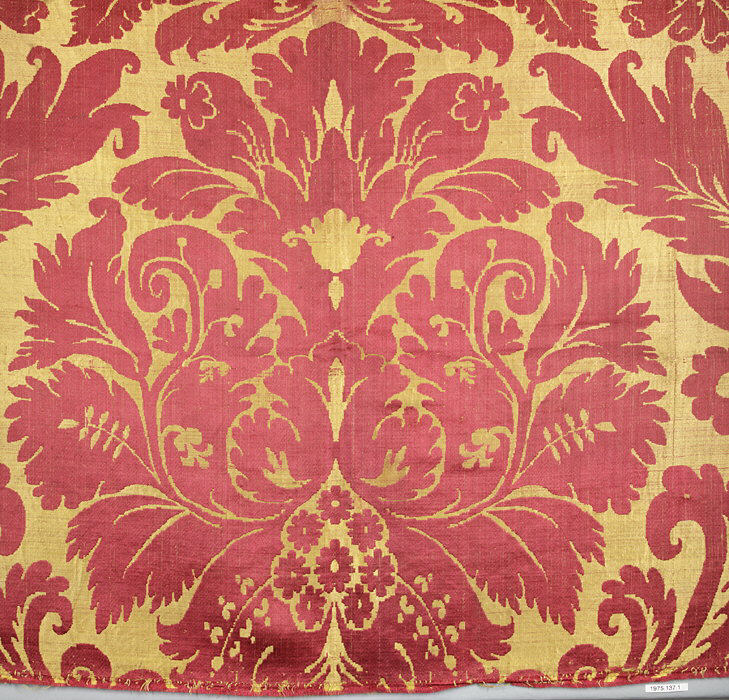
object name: piece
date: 1601-1700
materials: linen, silk